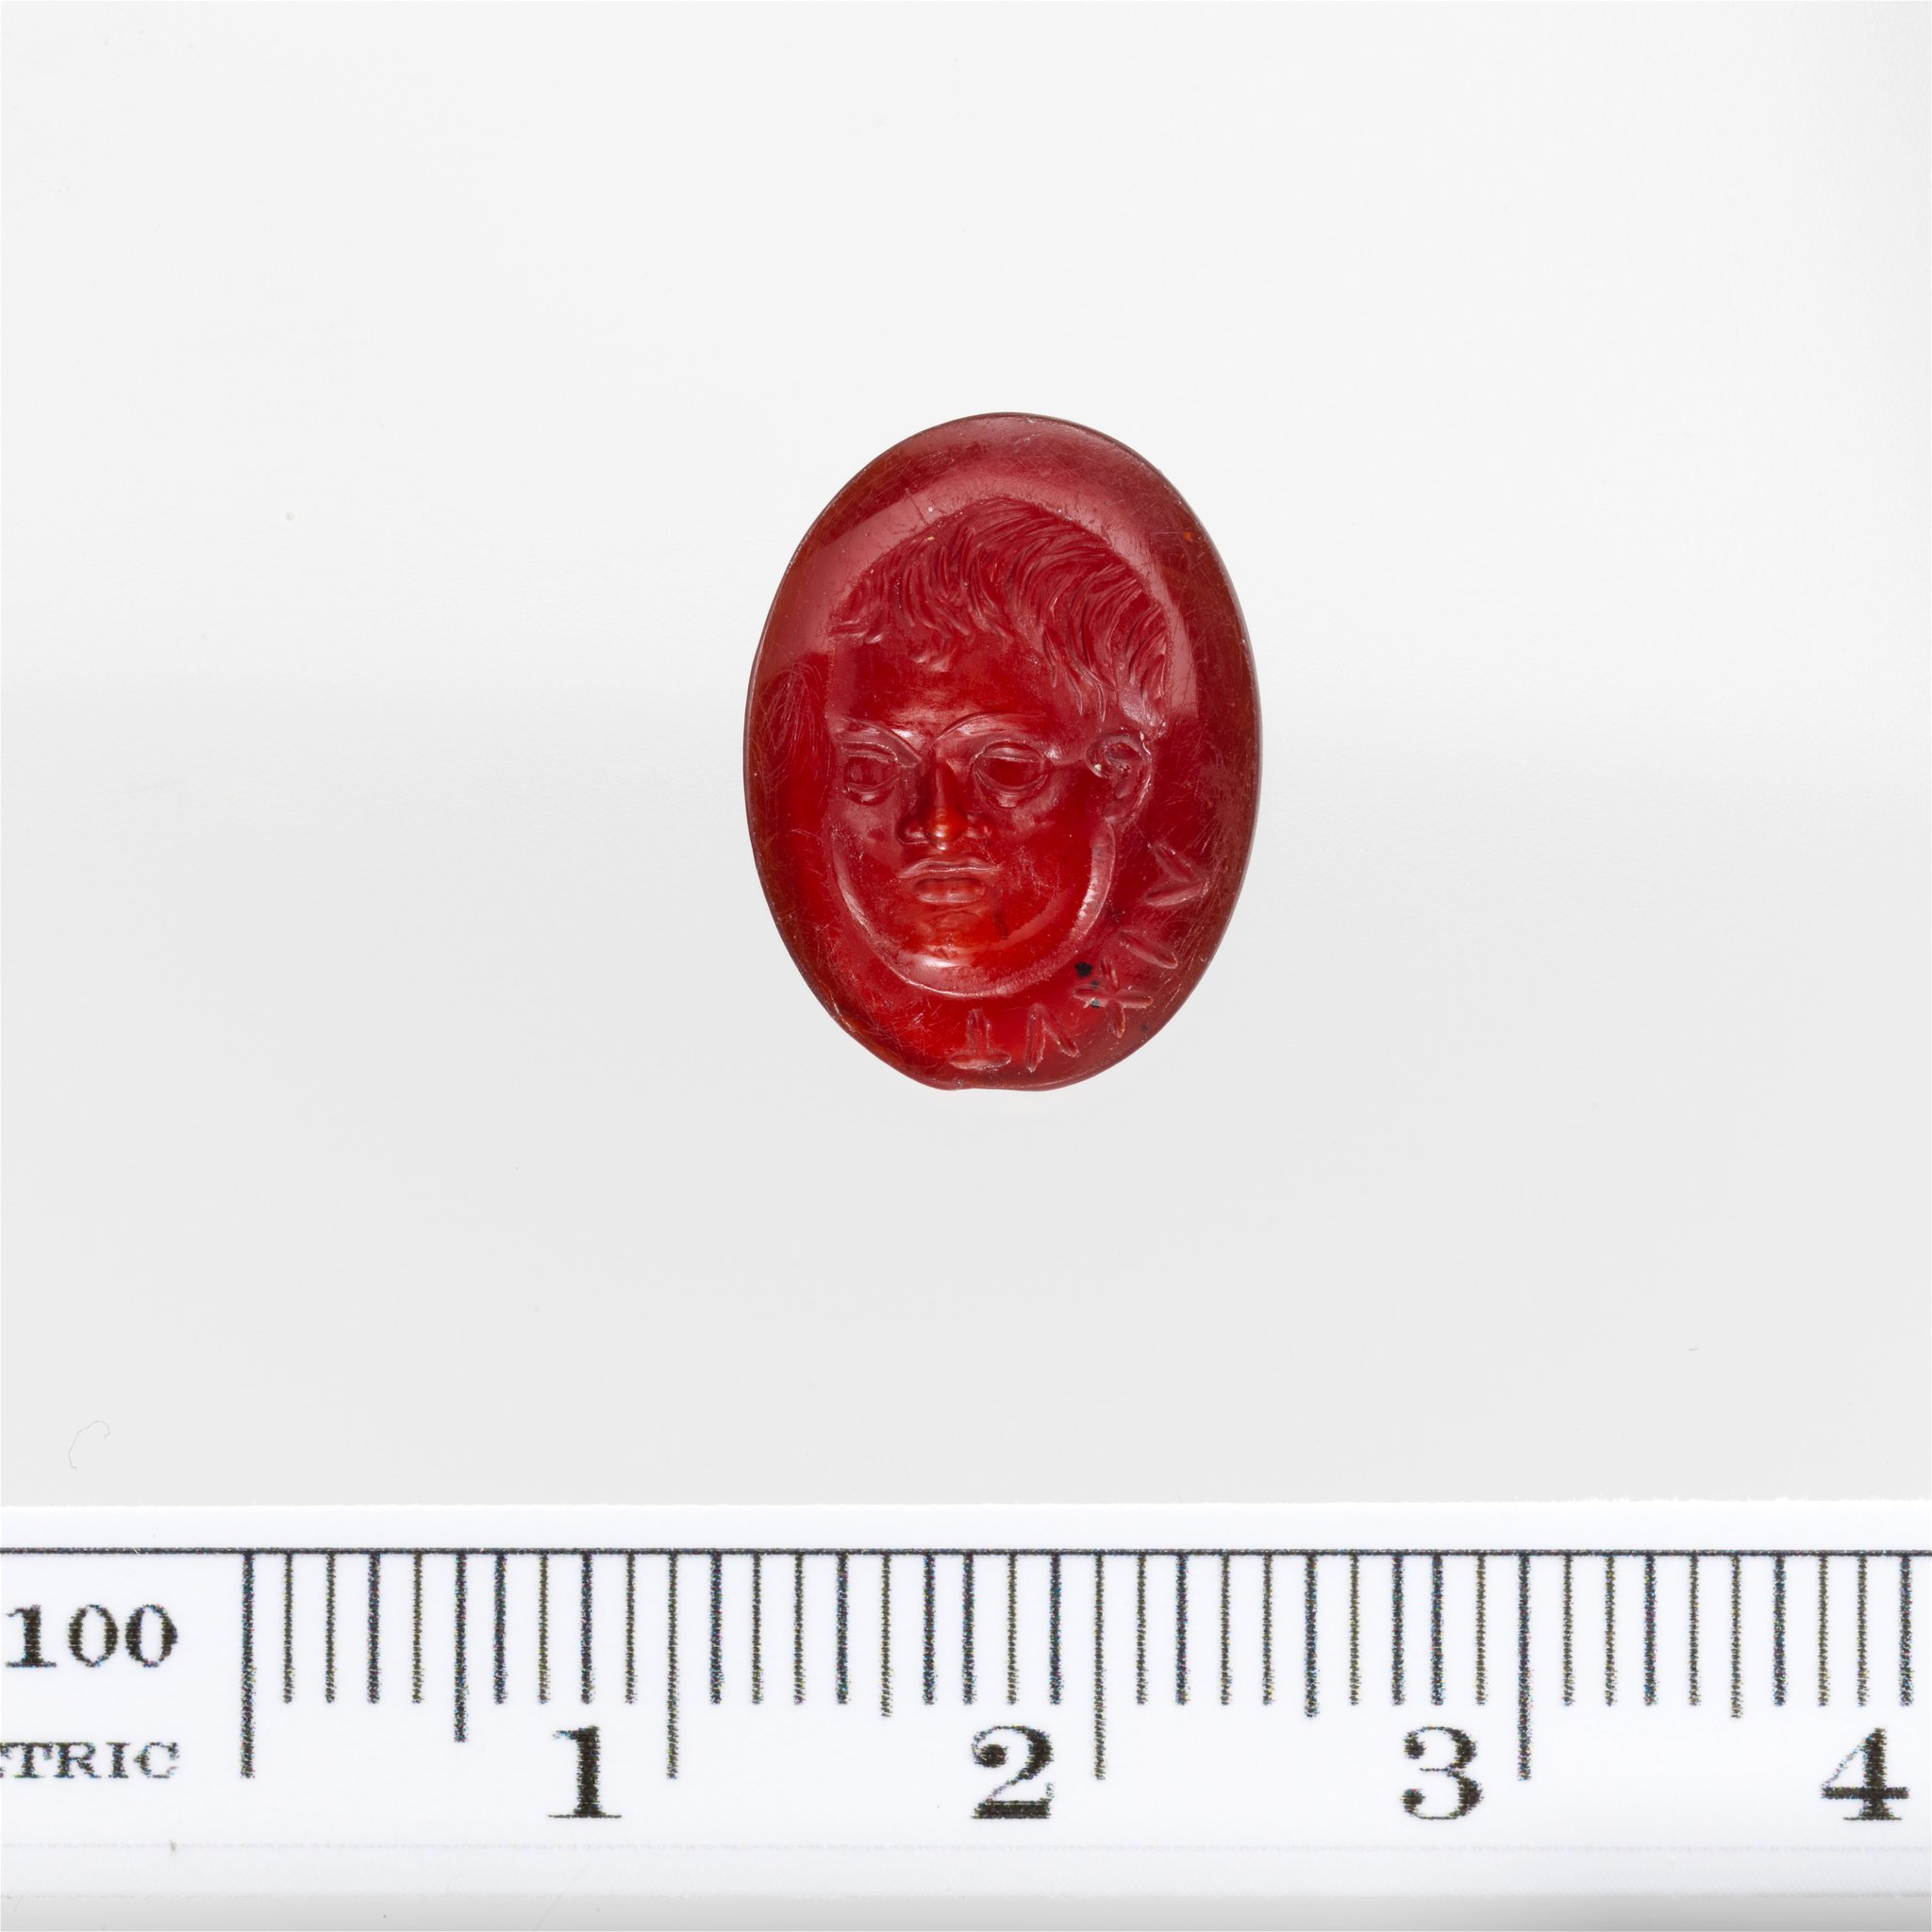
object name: intaglio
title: Carnelian ring stone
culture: roman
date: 69-96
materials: gemstone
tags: heads,children